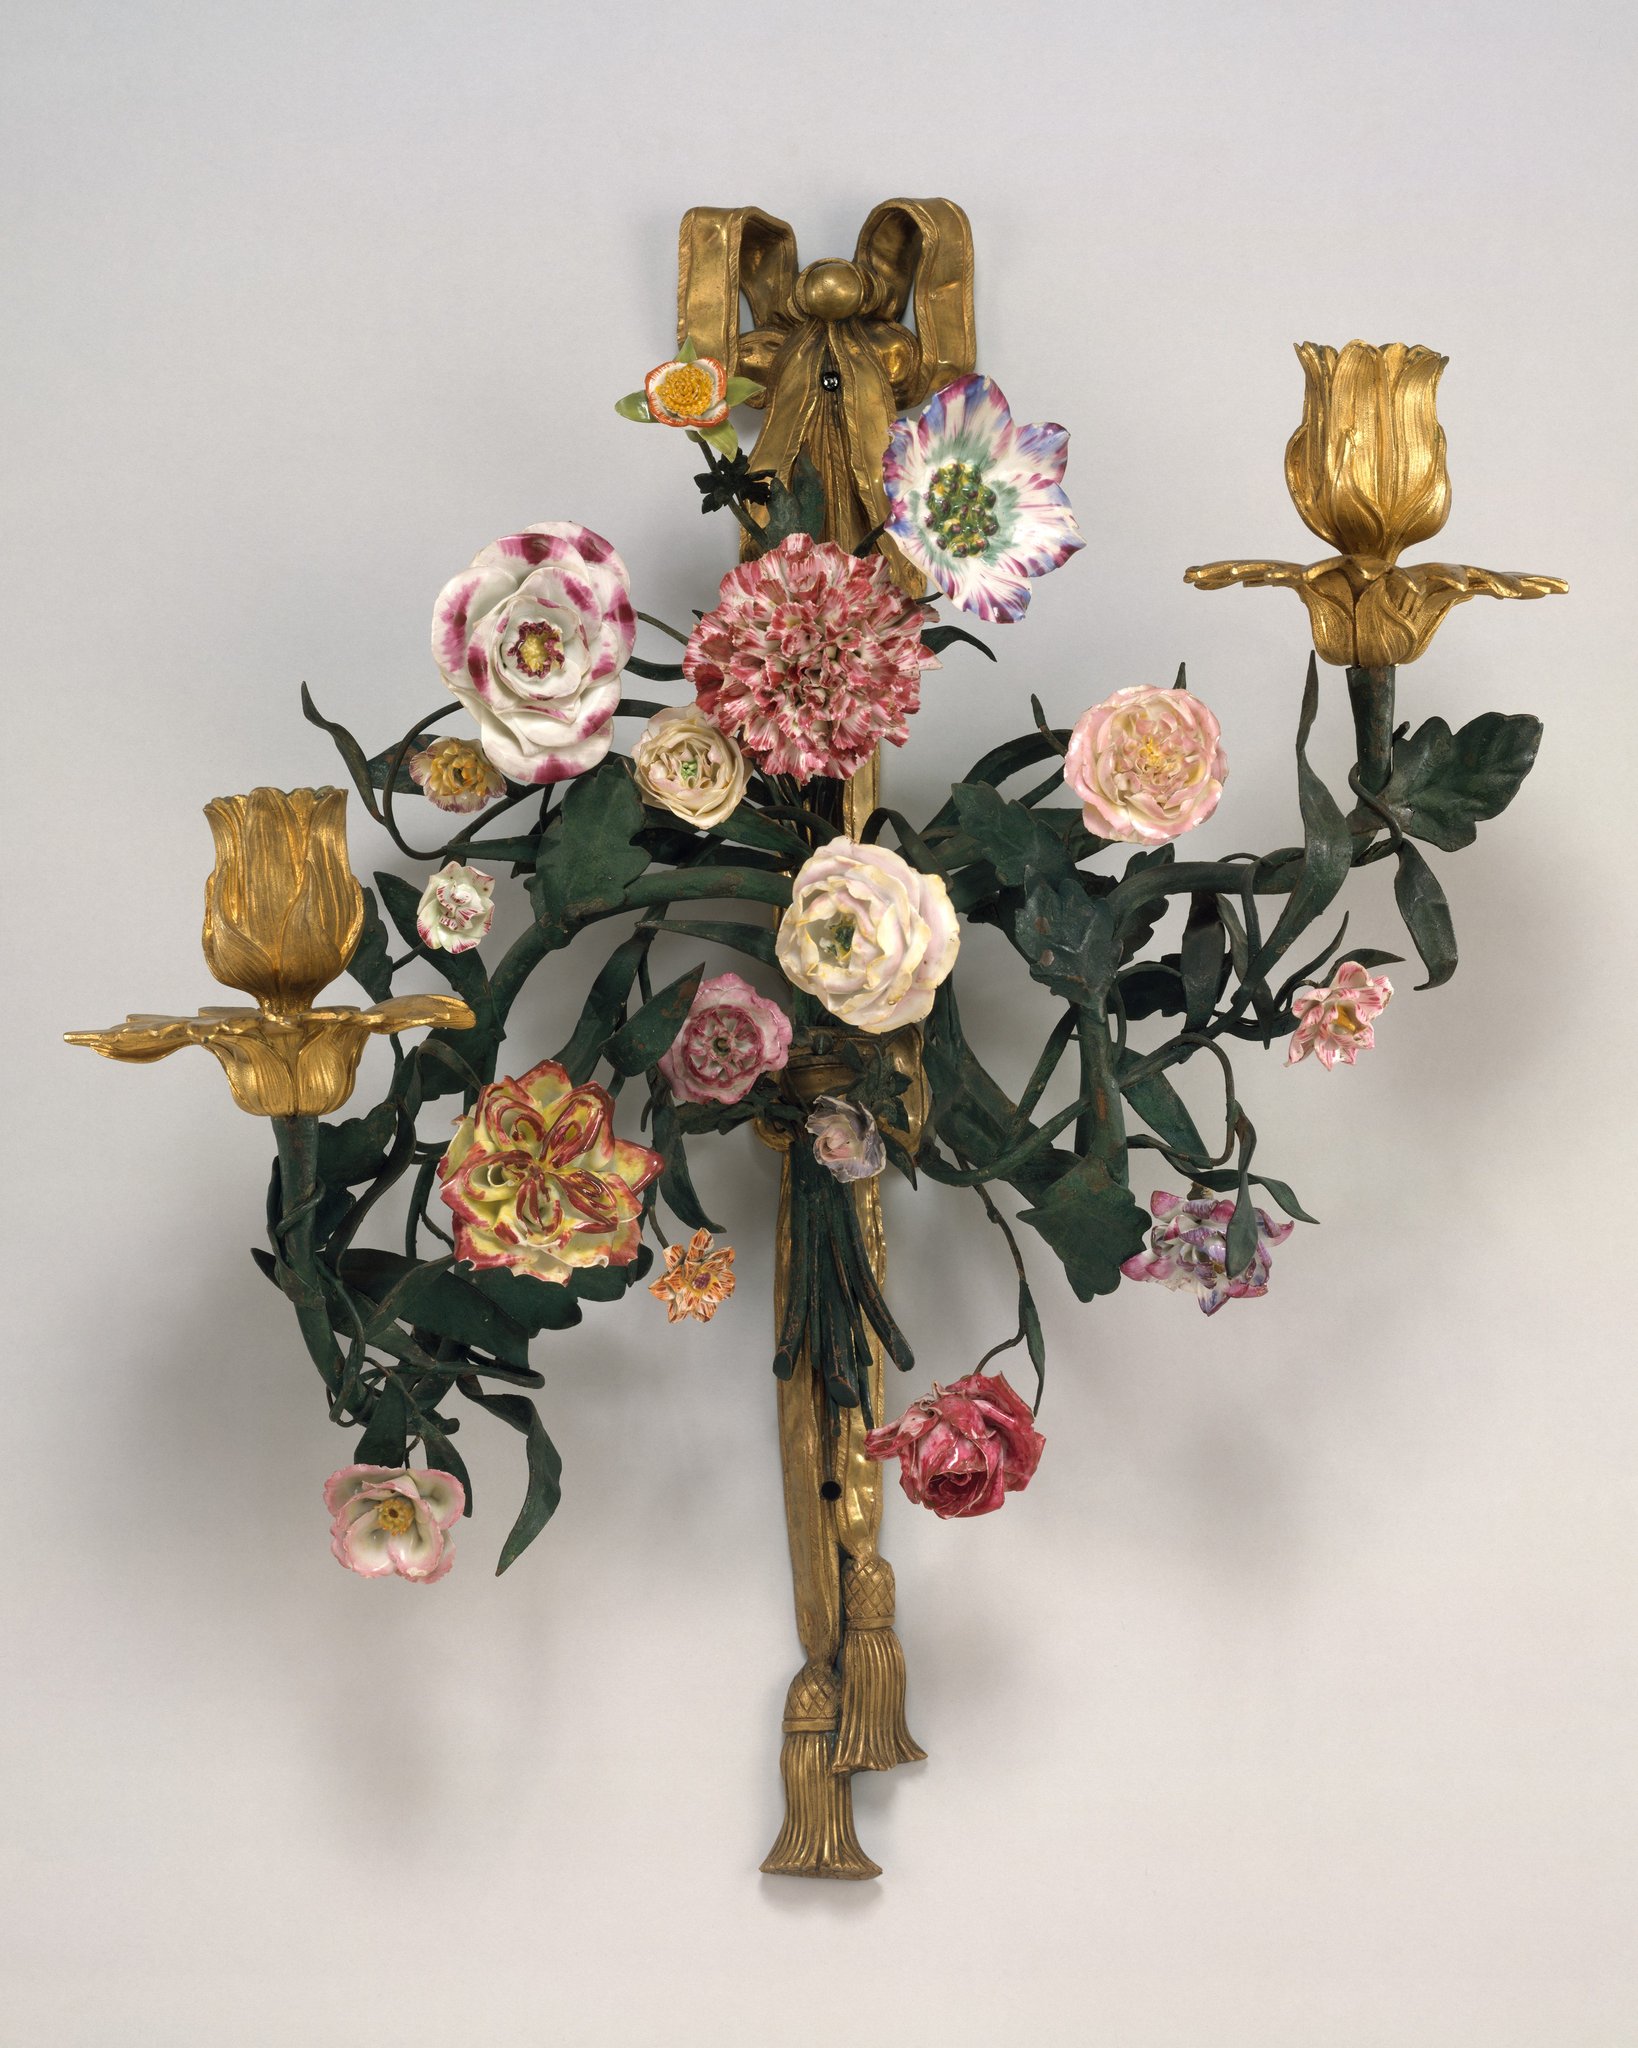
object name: wall light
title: Pair of wall lights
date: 1750-1760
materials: gilt bronze, hard paste porcelain, iron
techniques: painting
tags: flowers